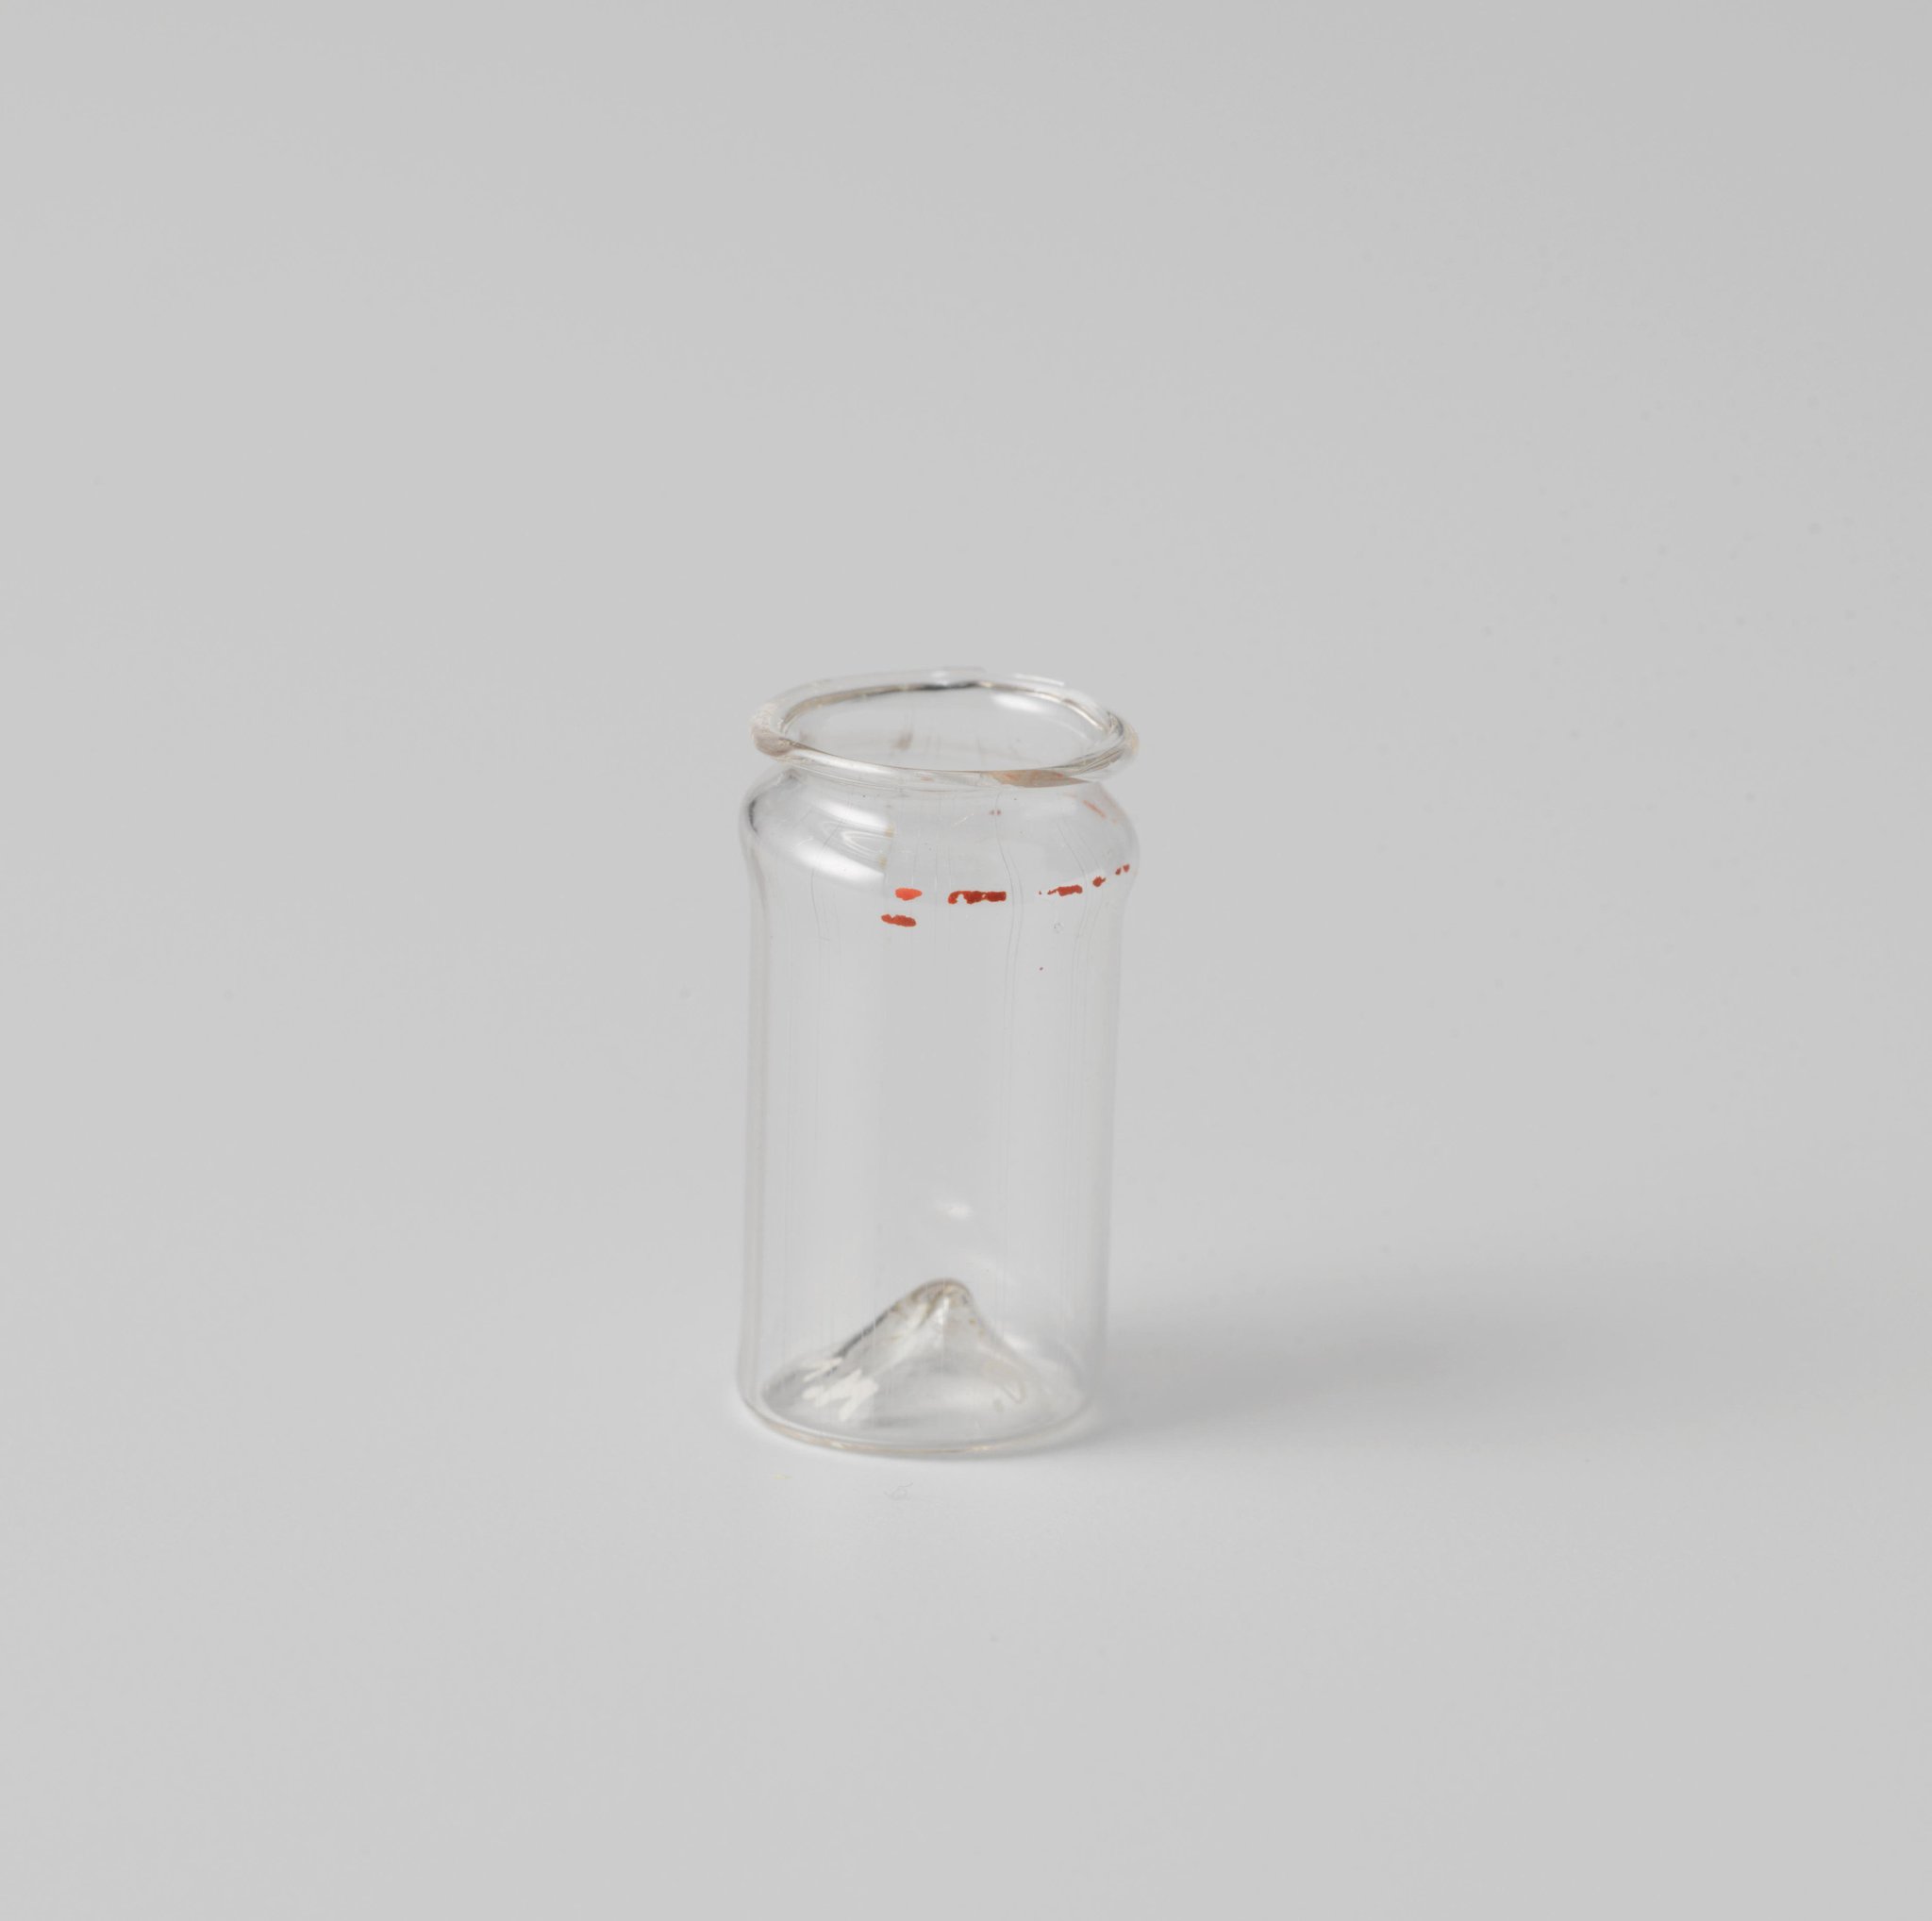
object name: storage jar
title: Voorraadglas, cilindervormig, met ingesnoerde hals en ingestoken bodem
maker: Anonymous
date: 1675-1699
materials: glass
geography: amsterdam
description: Voorraadglas, cilindrisch, van helder kleurloos glas met iets vernauwende hals en naar binnen gestoken bodem.